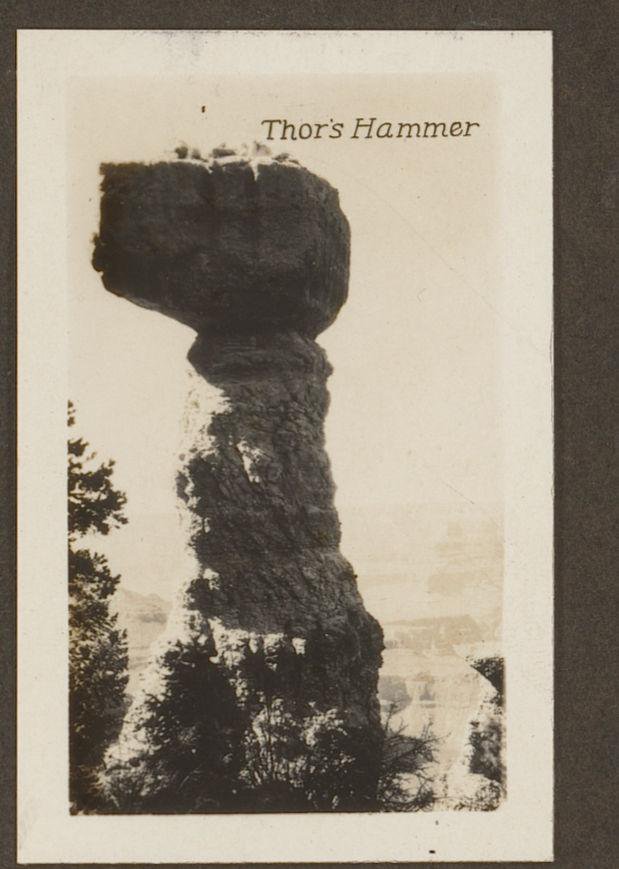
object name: album leaf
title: Thor's Hammer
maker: Anonymous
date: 1928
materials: photographic support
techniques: gelatin silver print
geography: grand canyon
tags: ravine, chasm, abyss, canyon, rock-formations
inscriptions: annotation: ‘Grand Canyon’